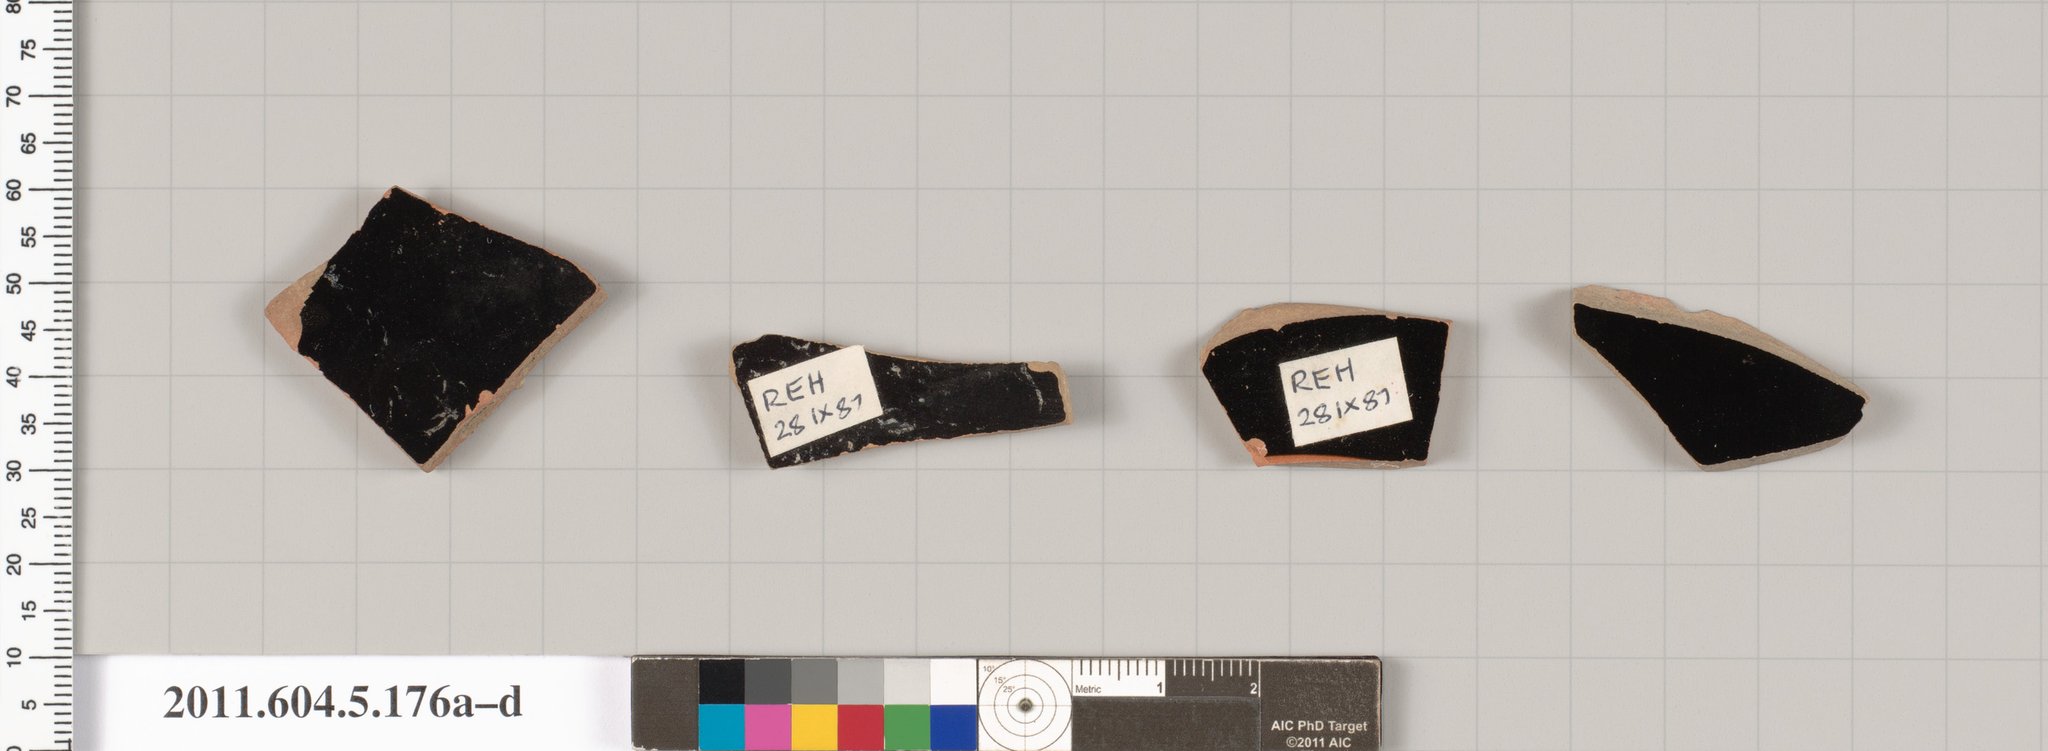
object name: kylix fragment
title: Terracotta fragments of kylikes (drinking cups)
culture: greek, attic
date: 600-401 BCE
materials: terracotta